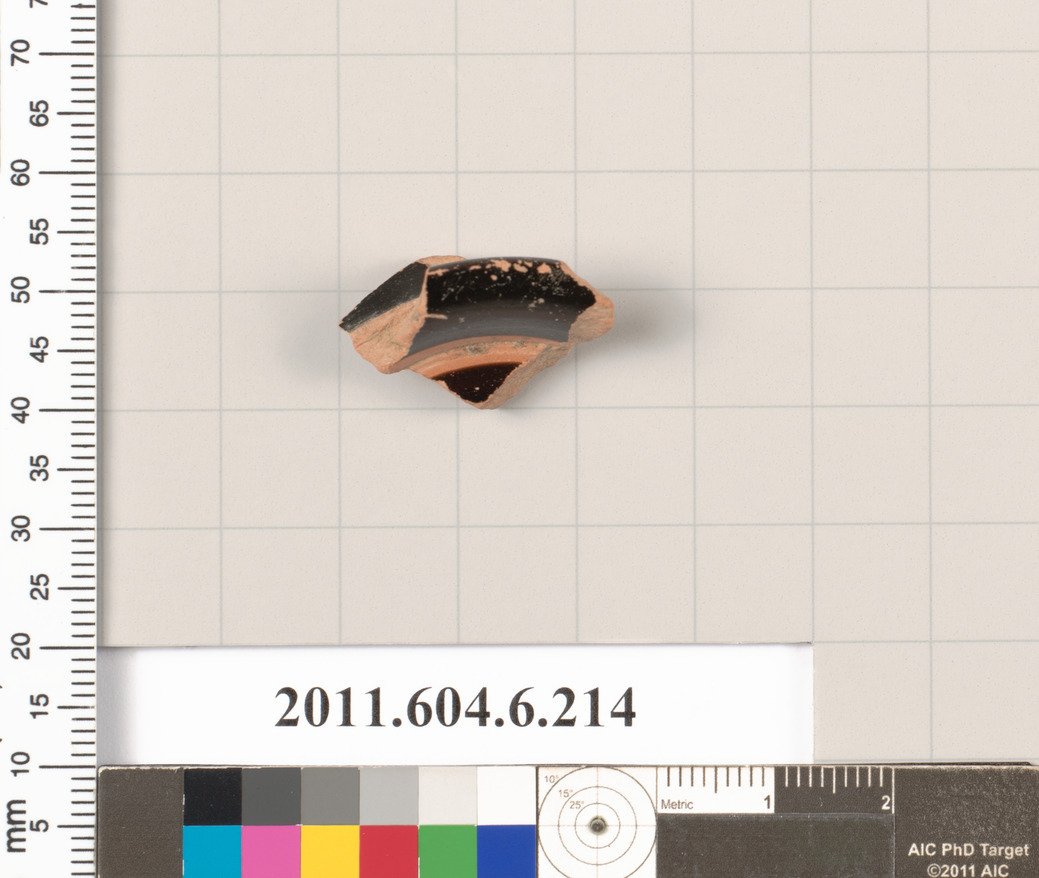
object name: skyphos fragment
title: Terracotta fragment of a skyphos (deep drinking cup)?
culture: greek, attic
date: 500-401 BCE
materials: terracotta